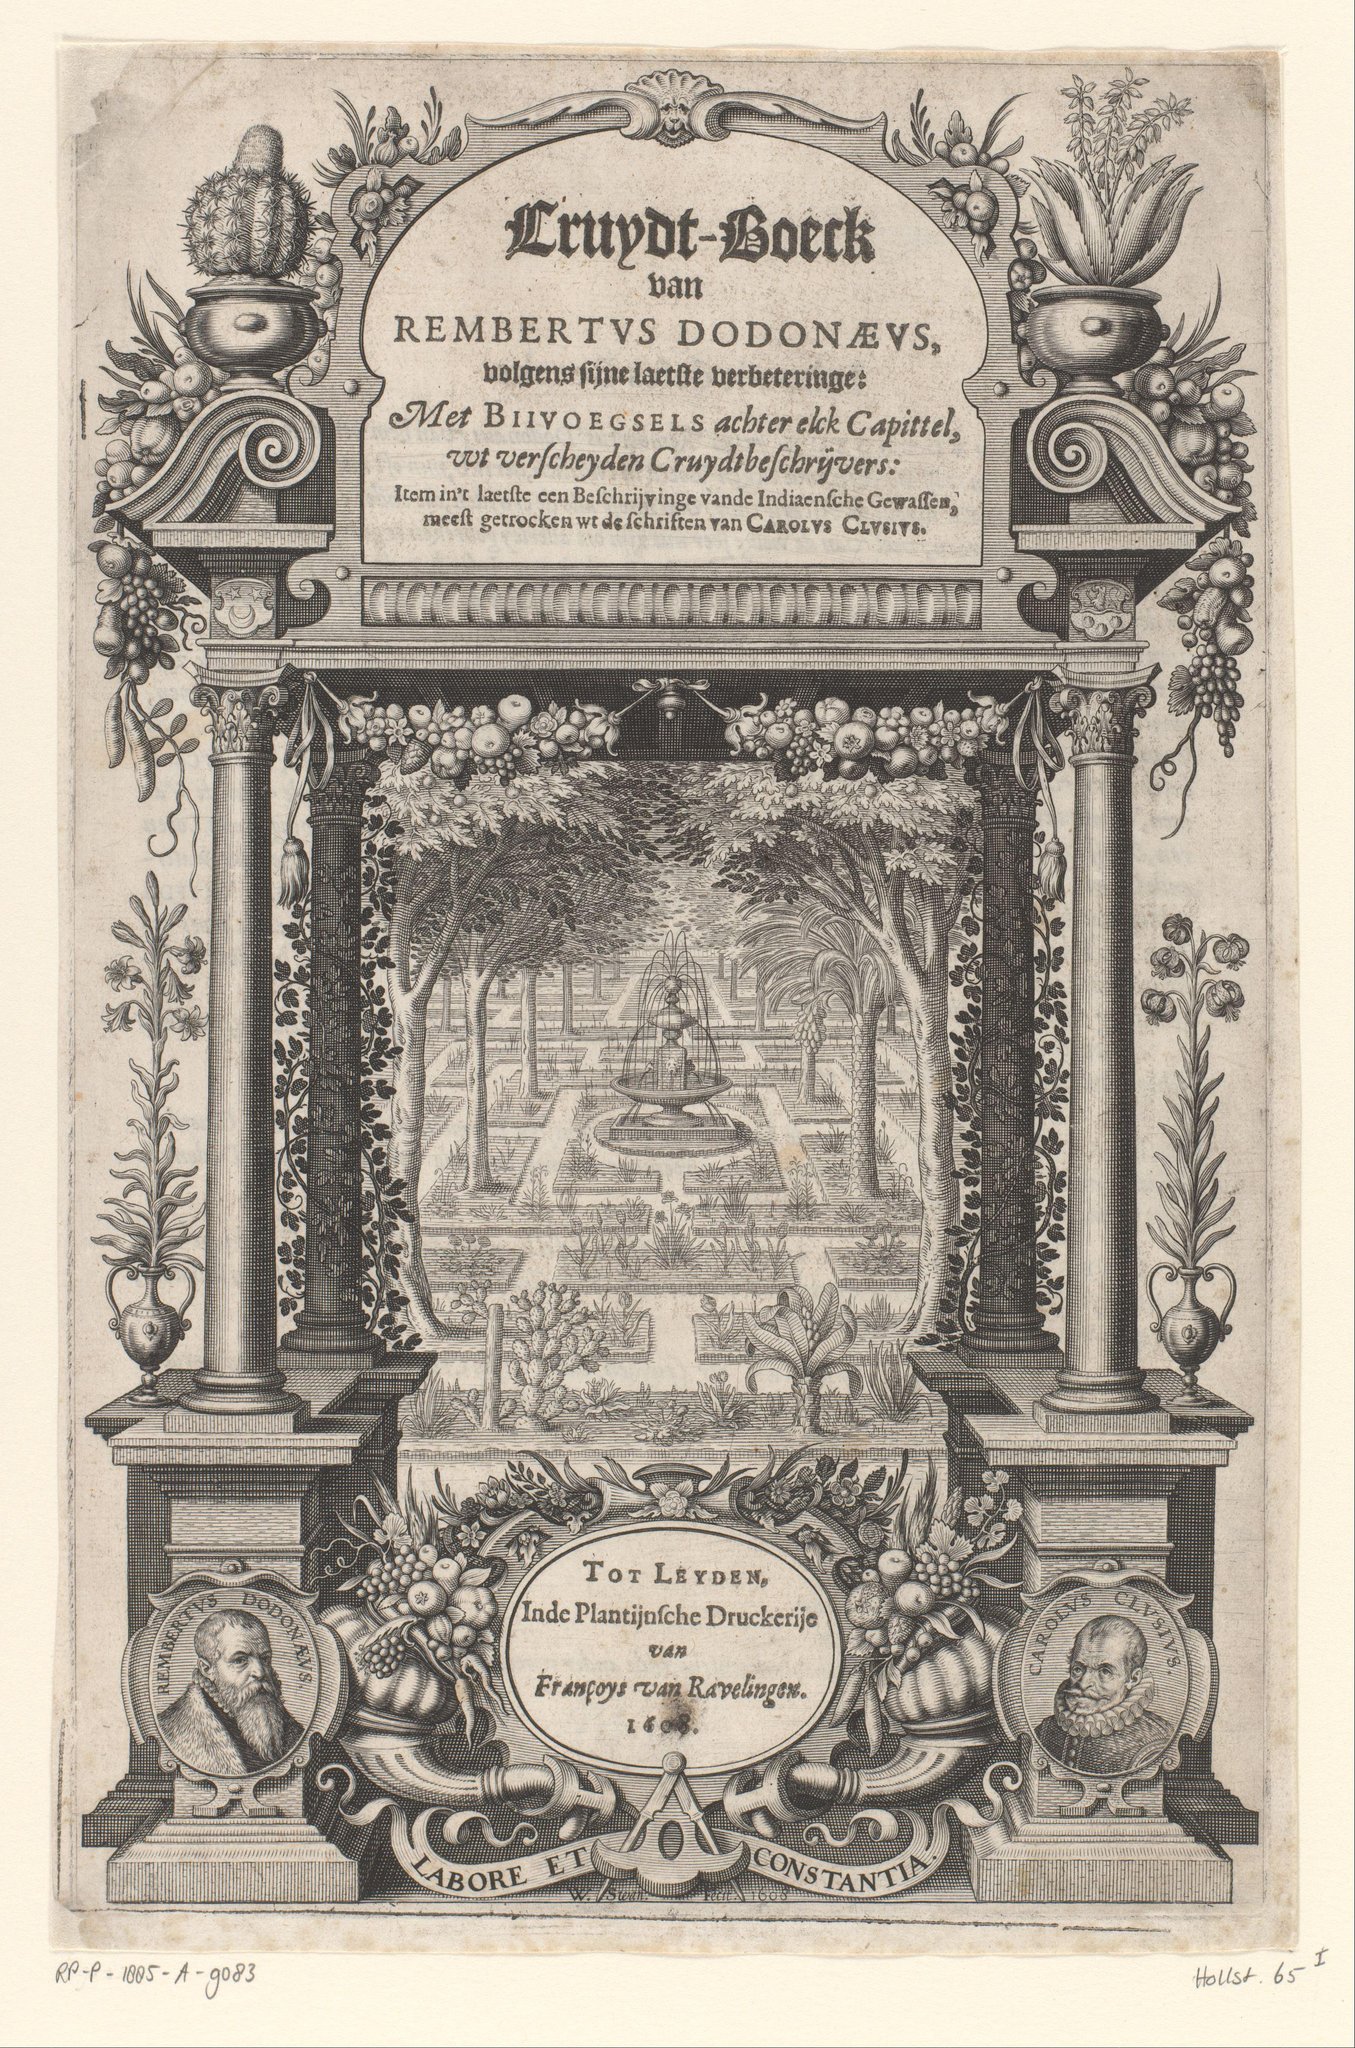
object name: print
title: Titelpagina voor: Rembertus Dodonaeus, Cruydt-boeck, 1608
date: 1608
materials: paper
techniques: engraving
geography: leiden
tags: rembertus dodonaeus, leiden, herb garden, 'cornucopia', horn of plenty, garden fountain, ornament ~ festoon, garland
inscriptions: collector's mark: Lugt 2228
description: Titelpagina voor de plantenatlas van Rembertus Dodonaeus. Door een bouwwerk met vier zuilen zicht op een kruidentuin met in het midden een fontein. Links- en rechtonder onder de zuilen cartouches met de portretten van Dodonaeus en Clusius. Rond het cartouche middenonder en langs het bouwwerk vruchten, bloemen en planten.